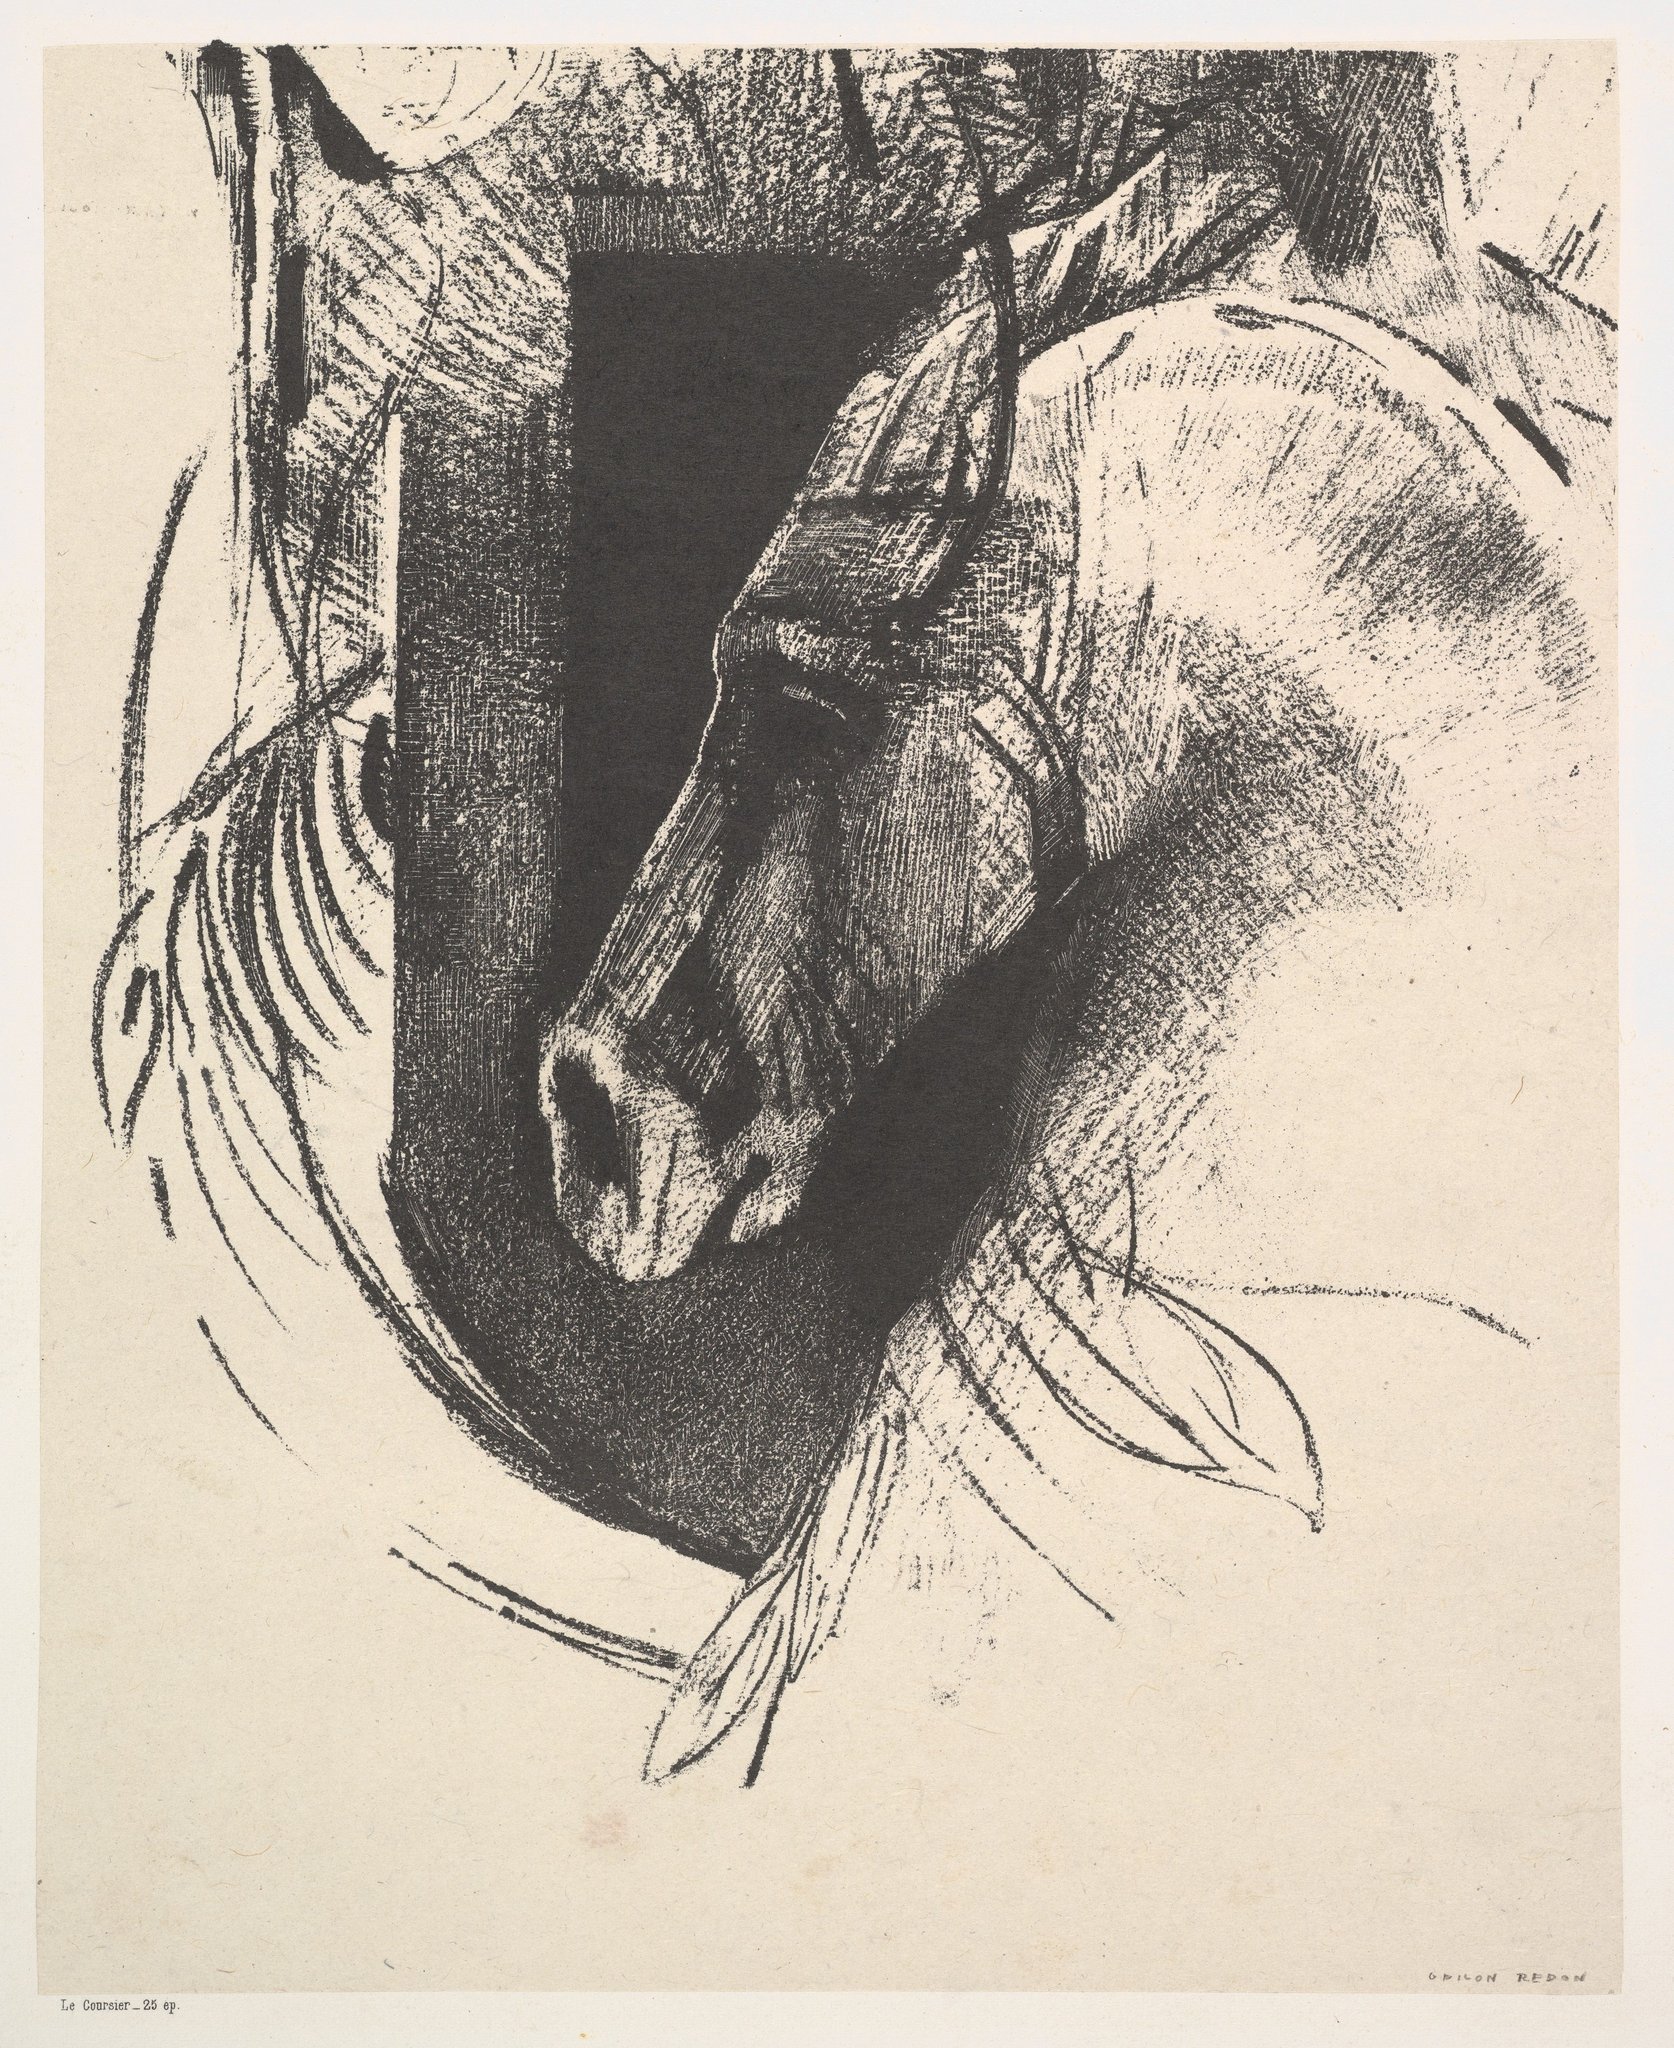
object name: print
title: The Charger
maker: odilon redon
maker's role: artist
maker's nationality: french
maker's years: 1840-1916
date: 1894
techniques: lithograph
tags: horses